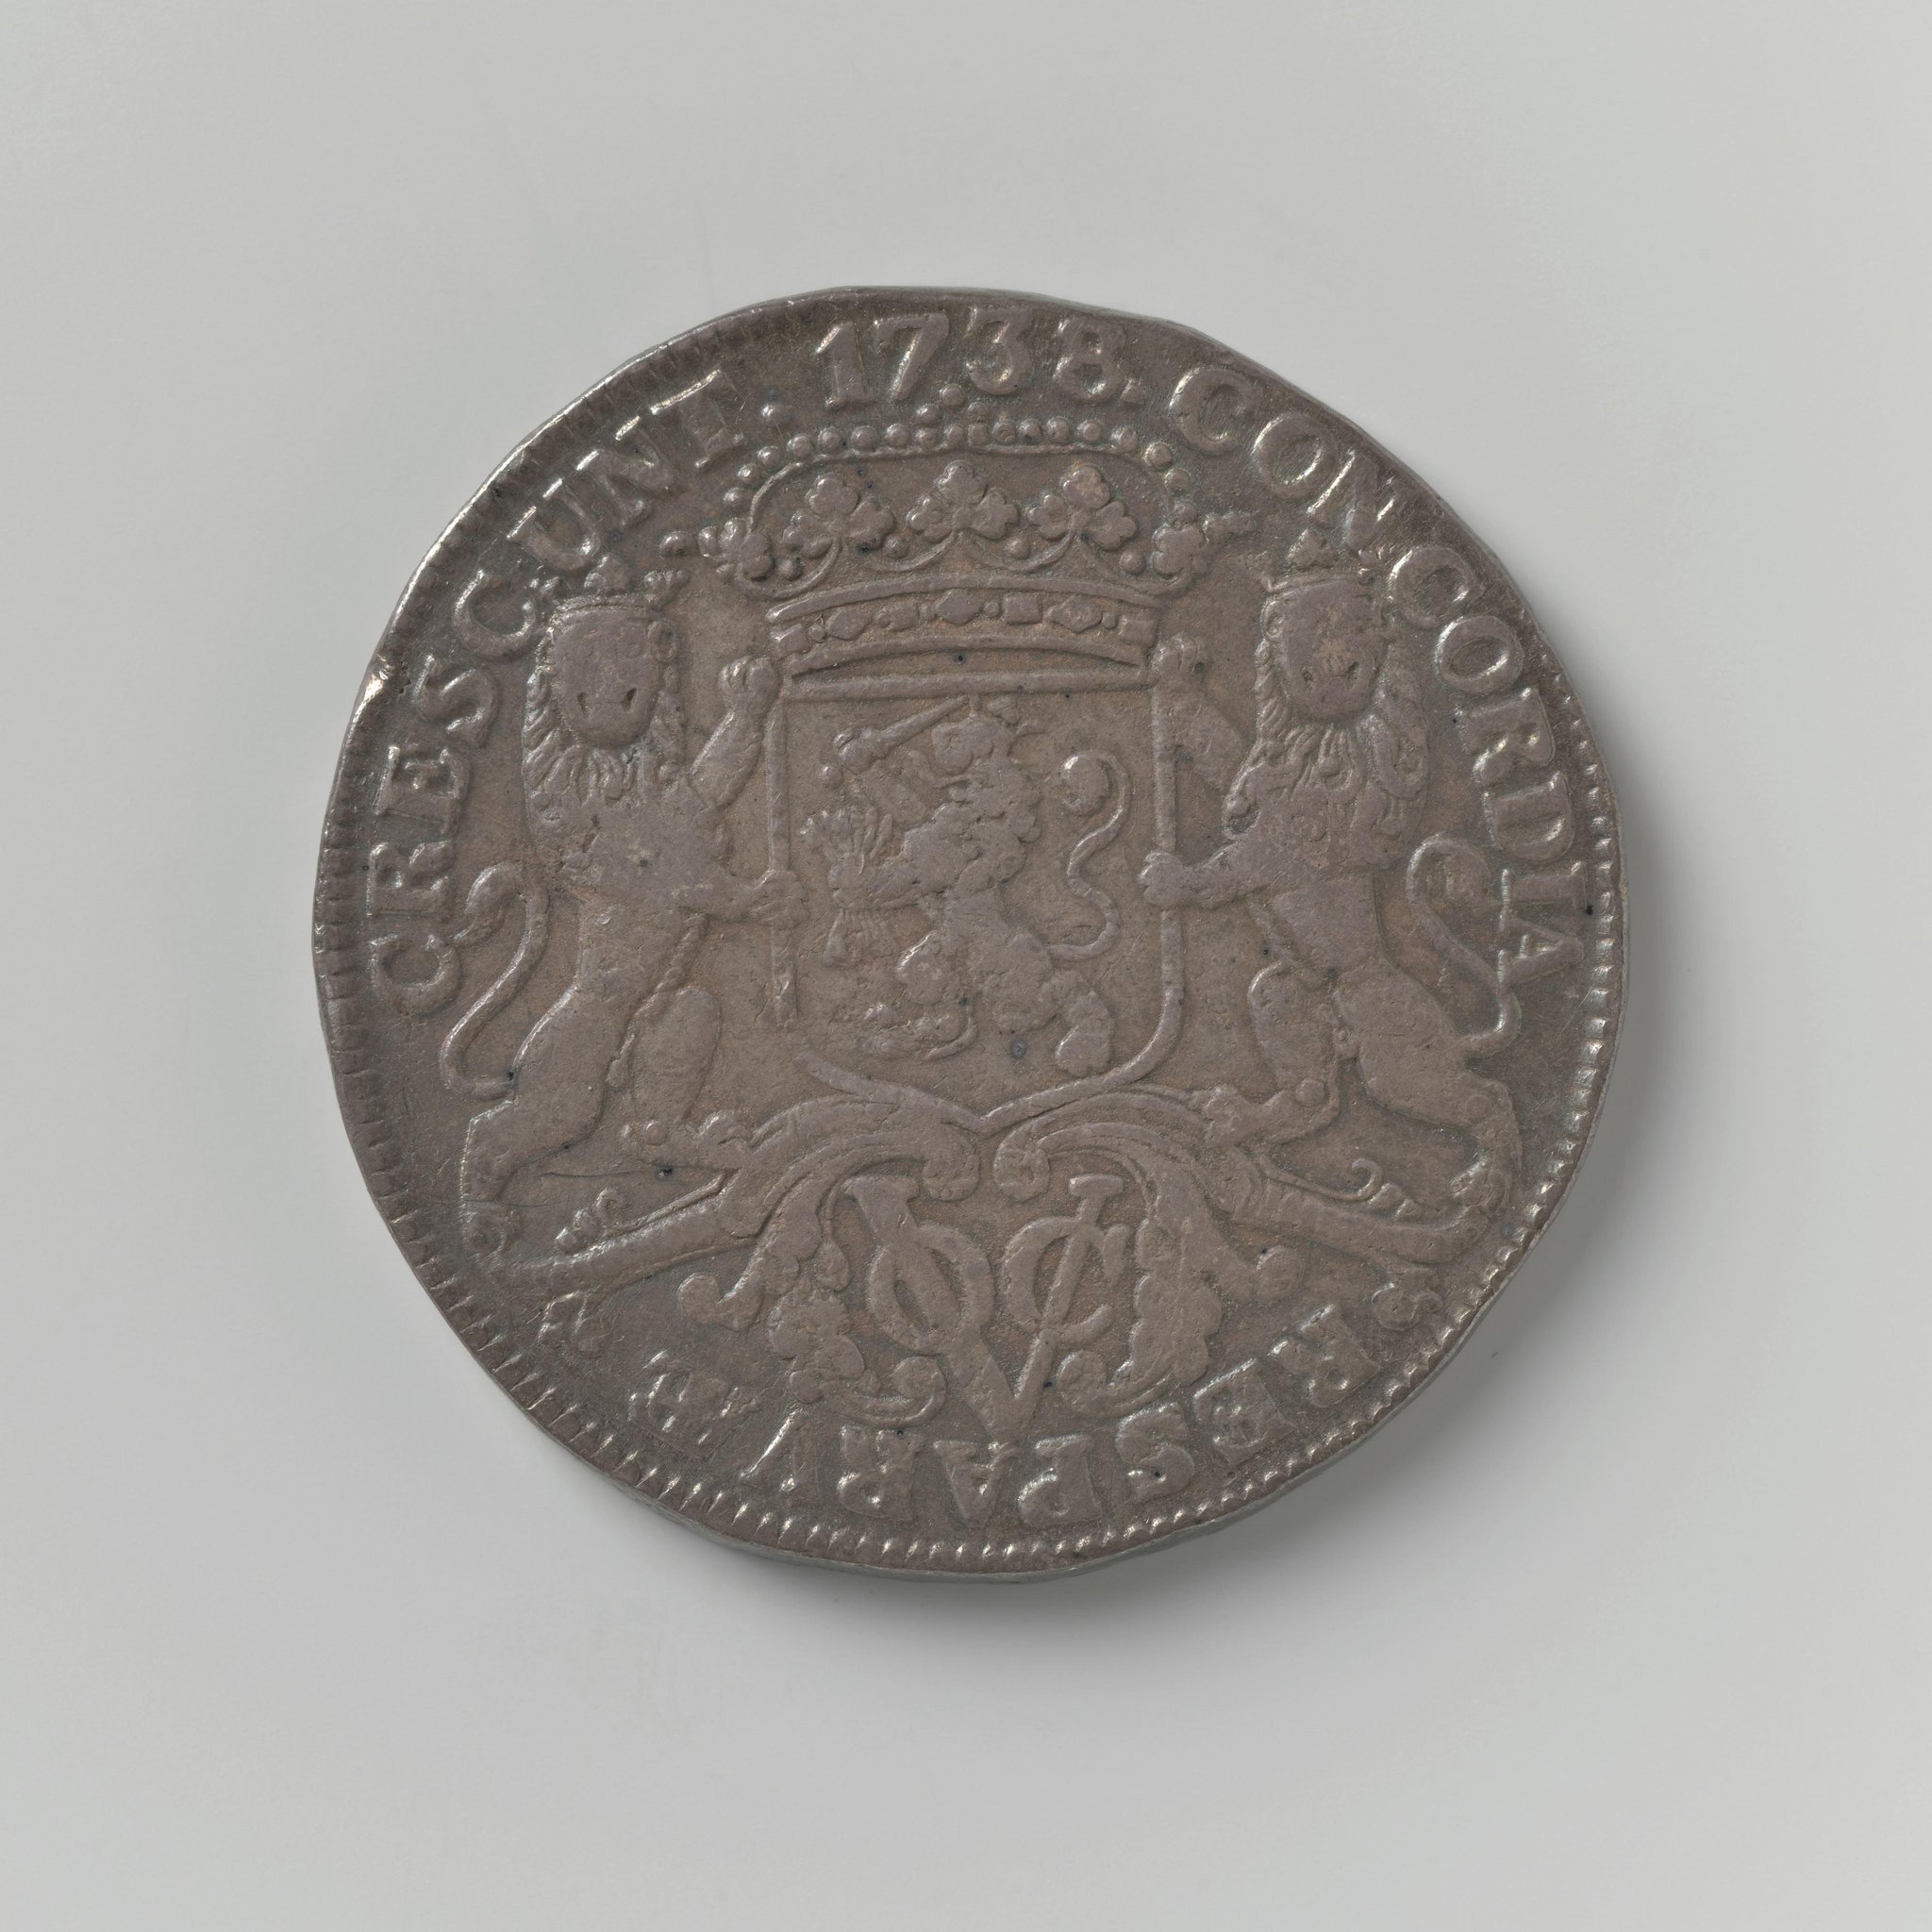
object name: coin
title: Zilveren rijder van de VOC uit Westfriesland, 1738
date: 1738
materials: silver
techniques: striking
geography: enkhuizen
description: Zilveren munt. Voorzijde: geharnaste ridder met zwaard te paard naar links, waaronder gekroond wapenschild van Westfriesland. Keerzijde: gekroond generaliteitswapenschild, waaronder cartouche, waarin monogram van de VOC. Jaartal in omschrift, boven kroon. Gladde rand.